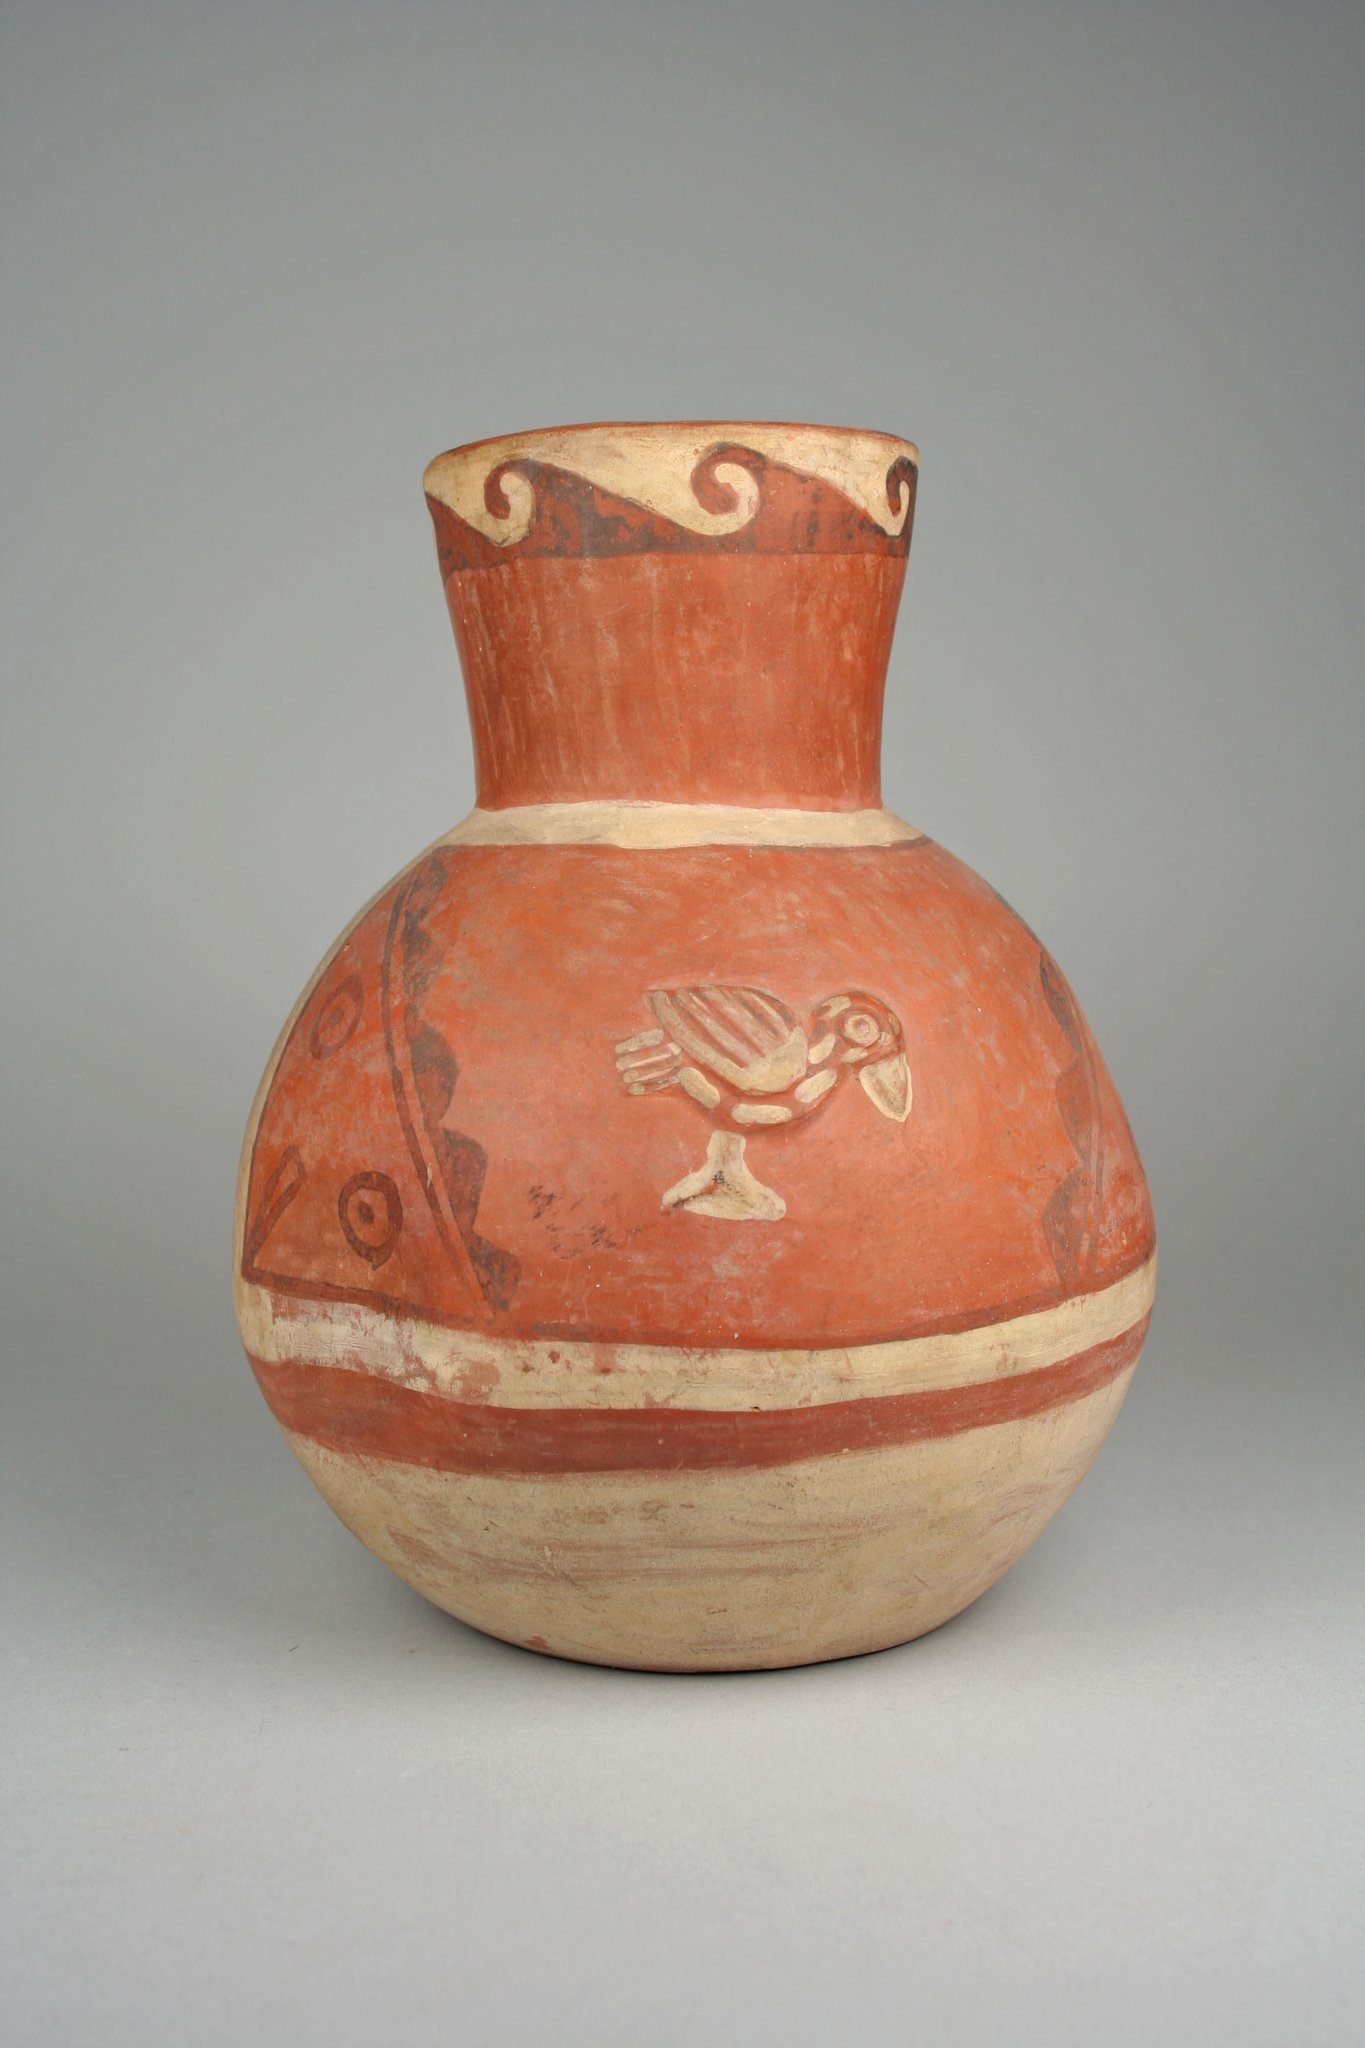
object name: bottle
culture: moche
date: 401-700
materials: ceramic, pigment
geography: peru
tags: birds